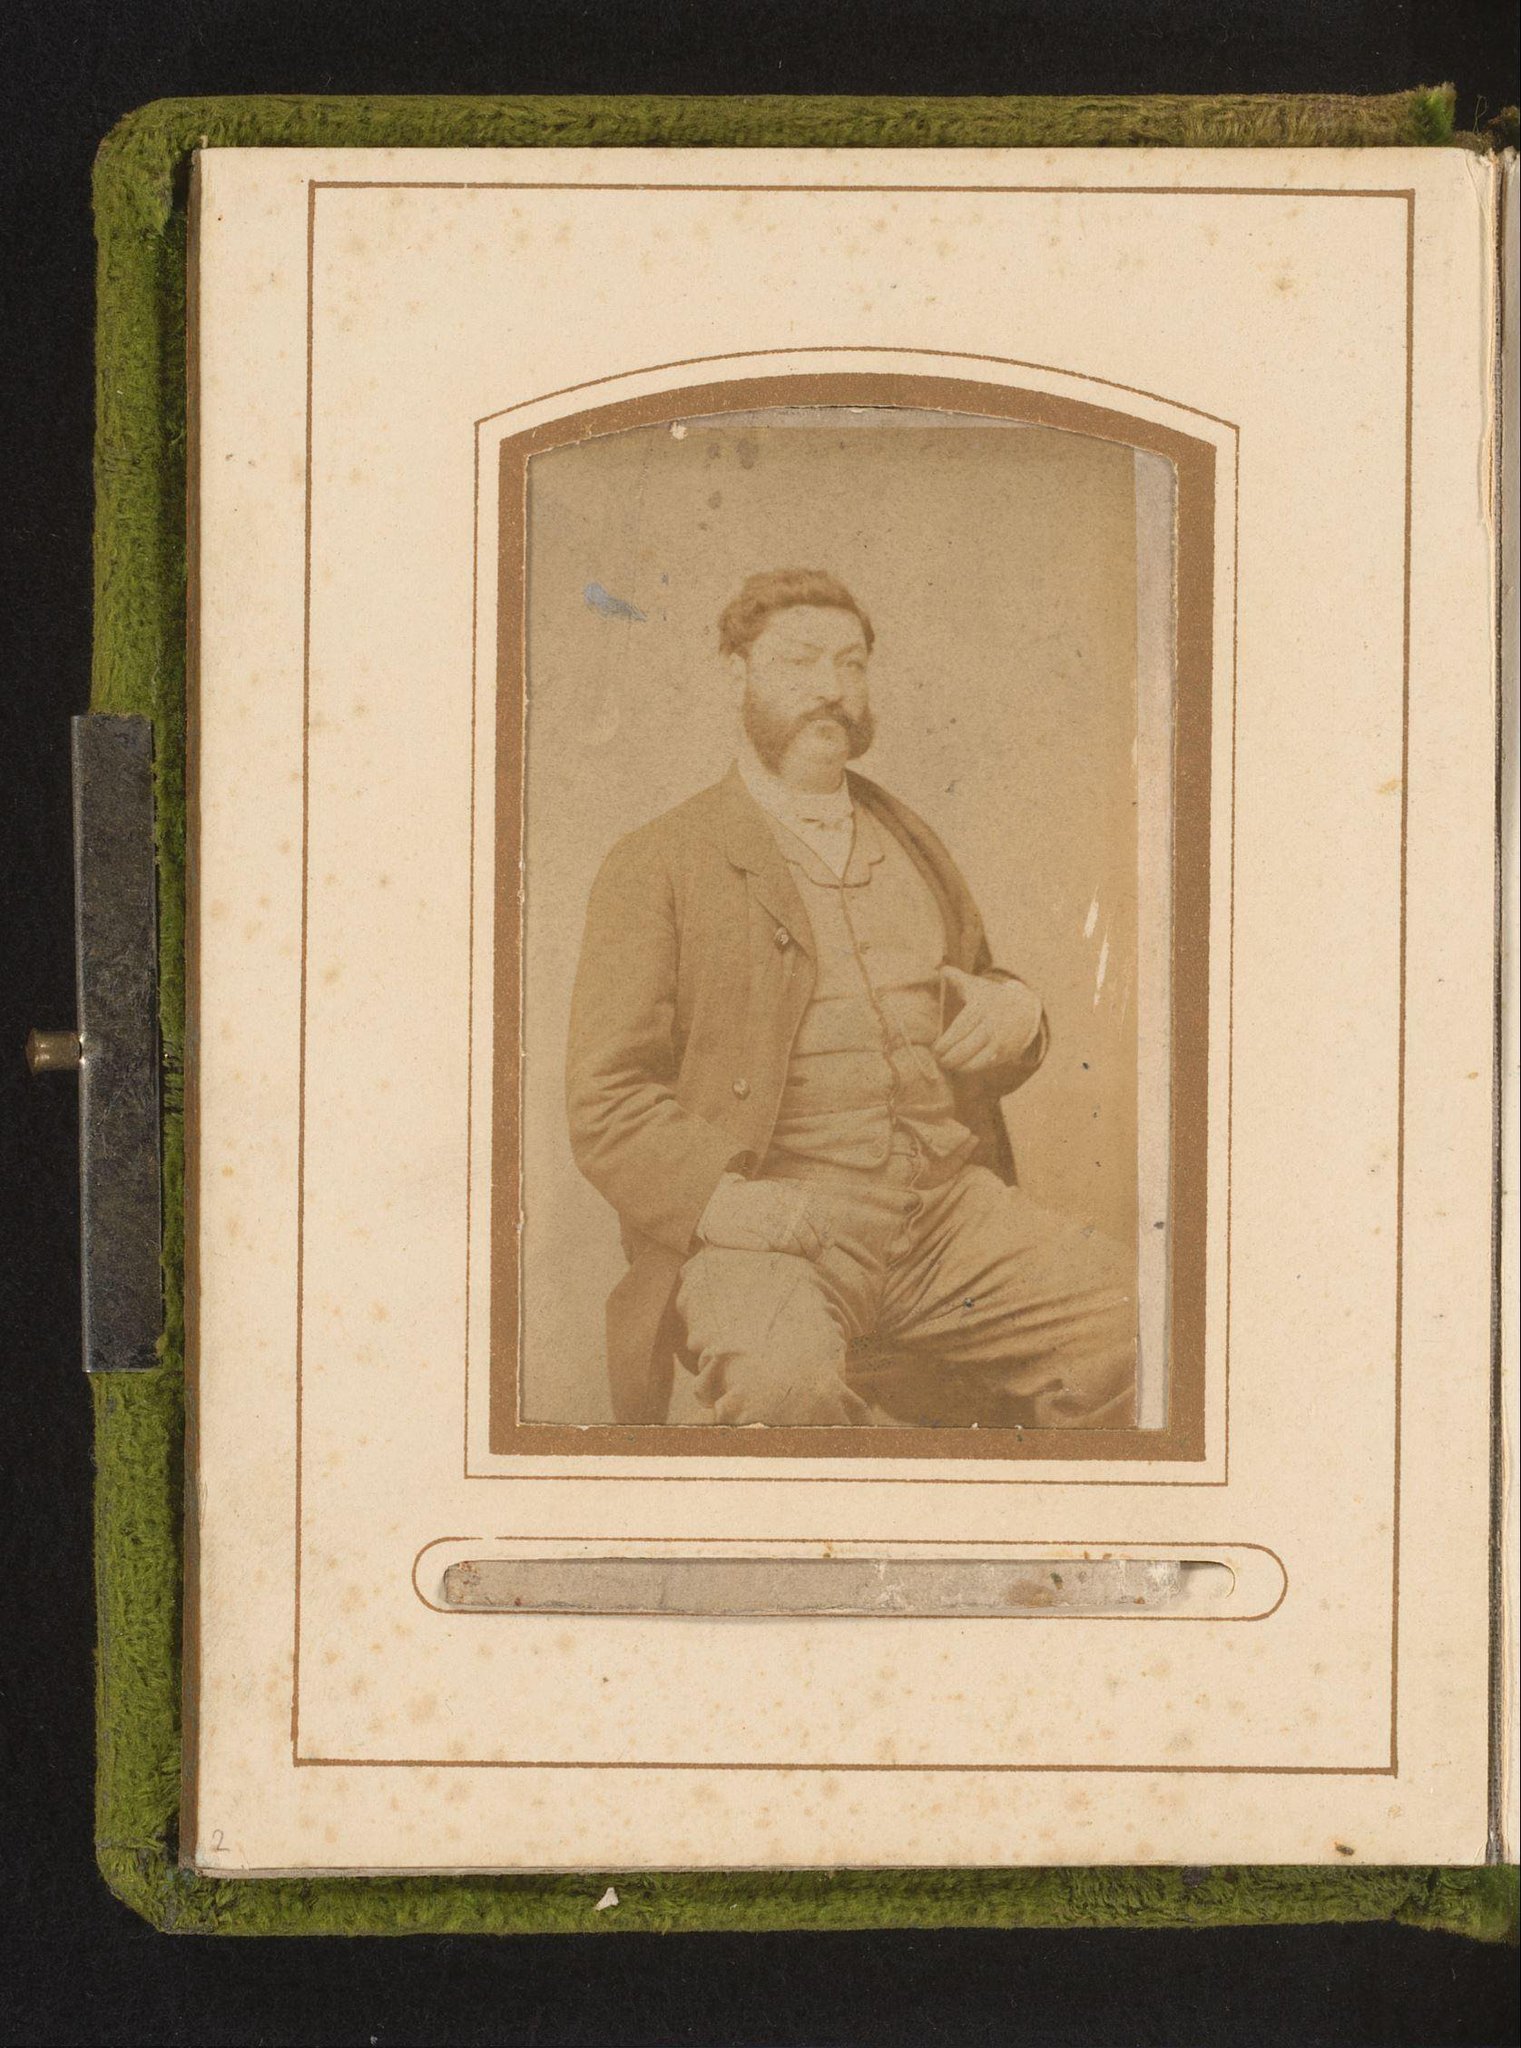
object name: album leaf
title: Portret van een man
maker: sabatier (fotograaf)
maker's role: fotograaf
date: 1860-1900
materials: cardboard, photographic support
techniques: albumen print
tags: sideburns, adult man, historical persons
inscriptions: inscription: ‘Sabatier/ Phottographie/ qu Puy/ (...)’